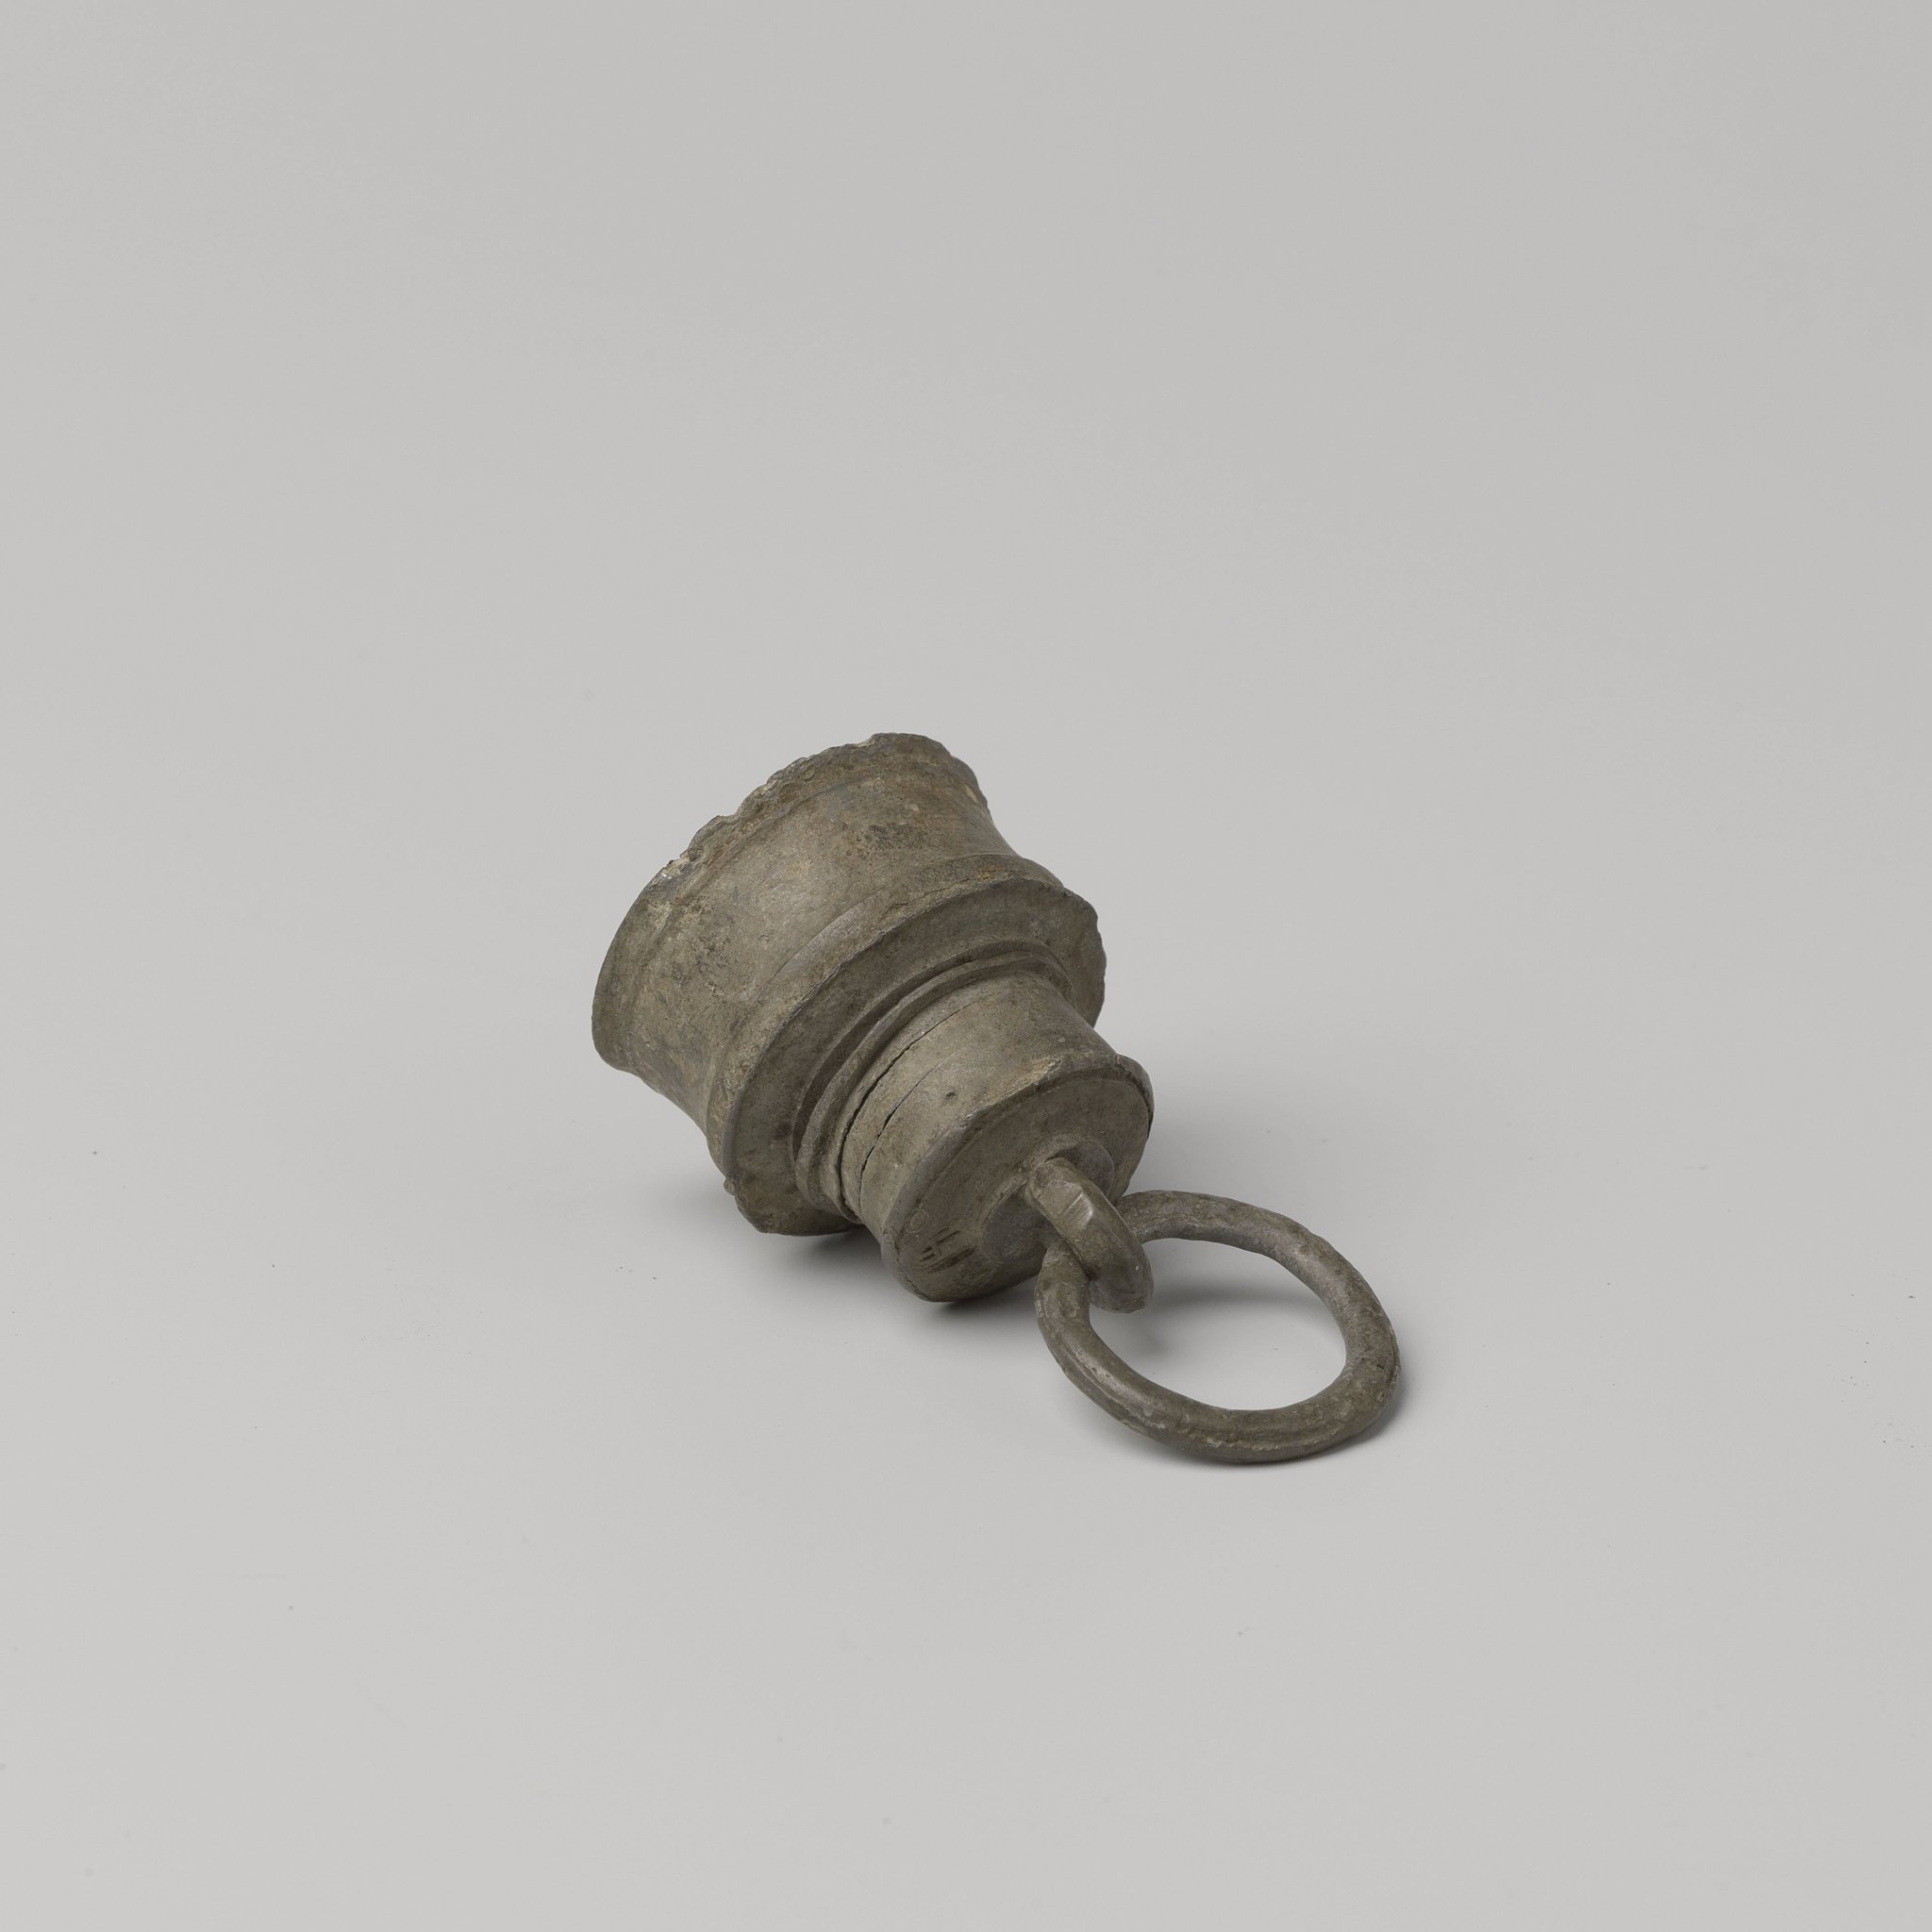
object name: bottle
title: Schroefsluiting van fles, fragment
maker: Anonymous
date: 1590-1596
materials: tin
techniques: casting, soldering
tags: willem barendsz., amsterdam, jacob van heemskerck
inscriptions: mark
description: Schroefsluiting van een fles, fragment met ring.